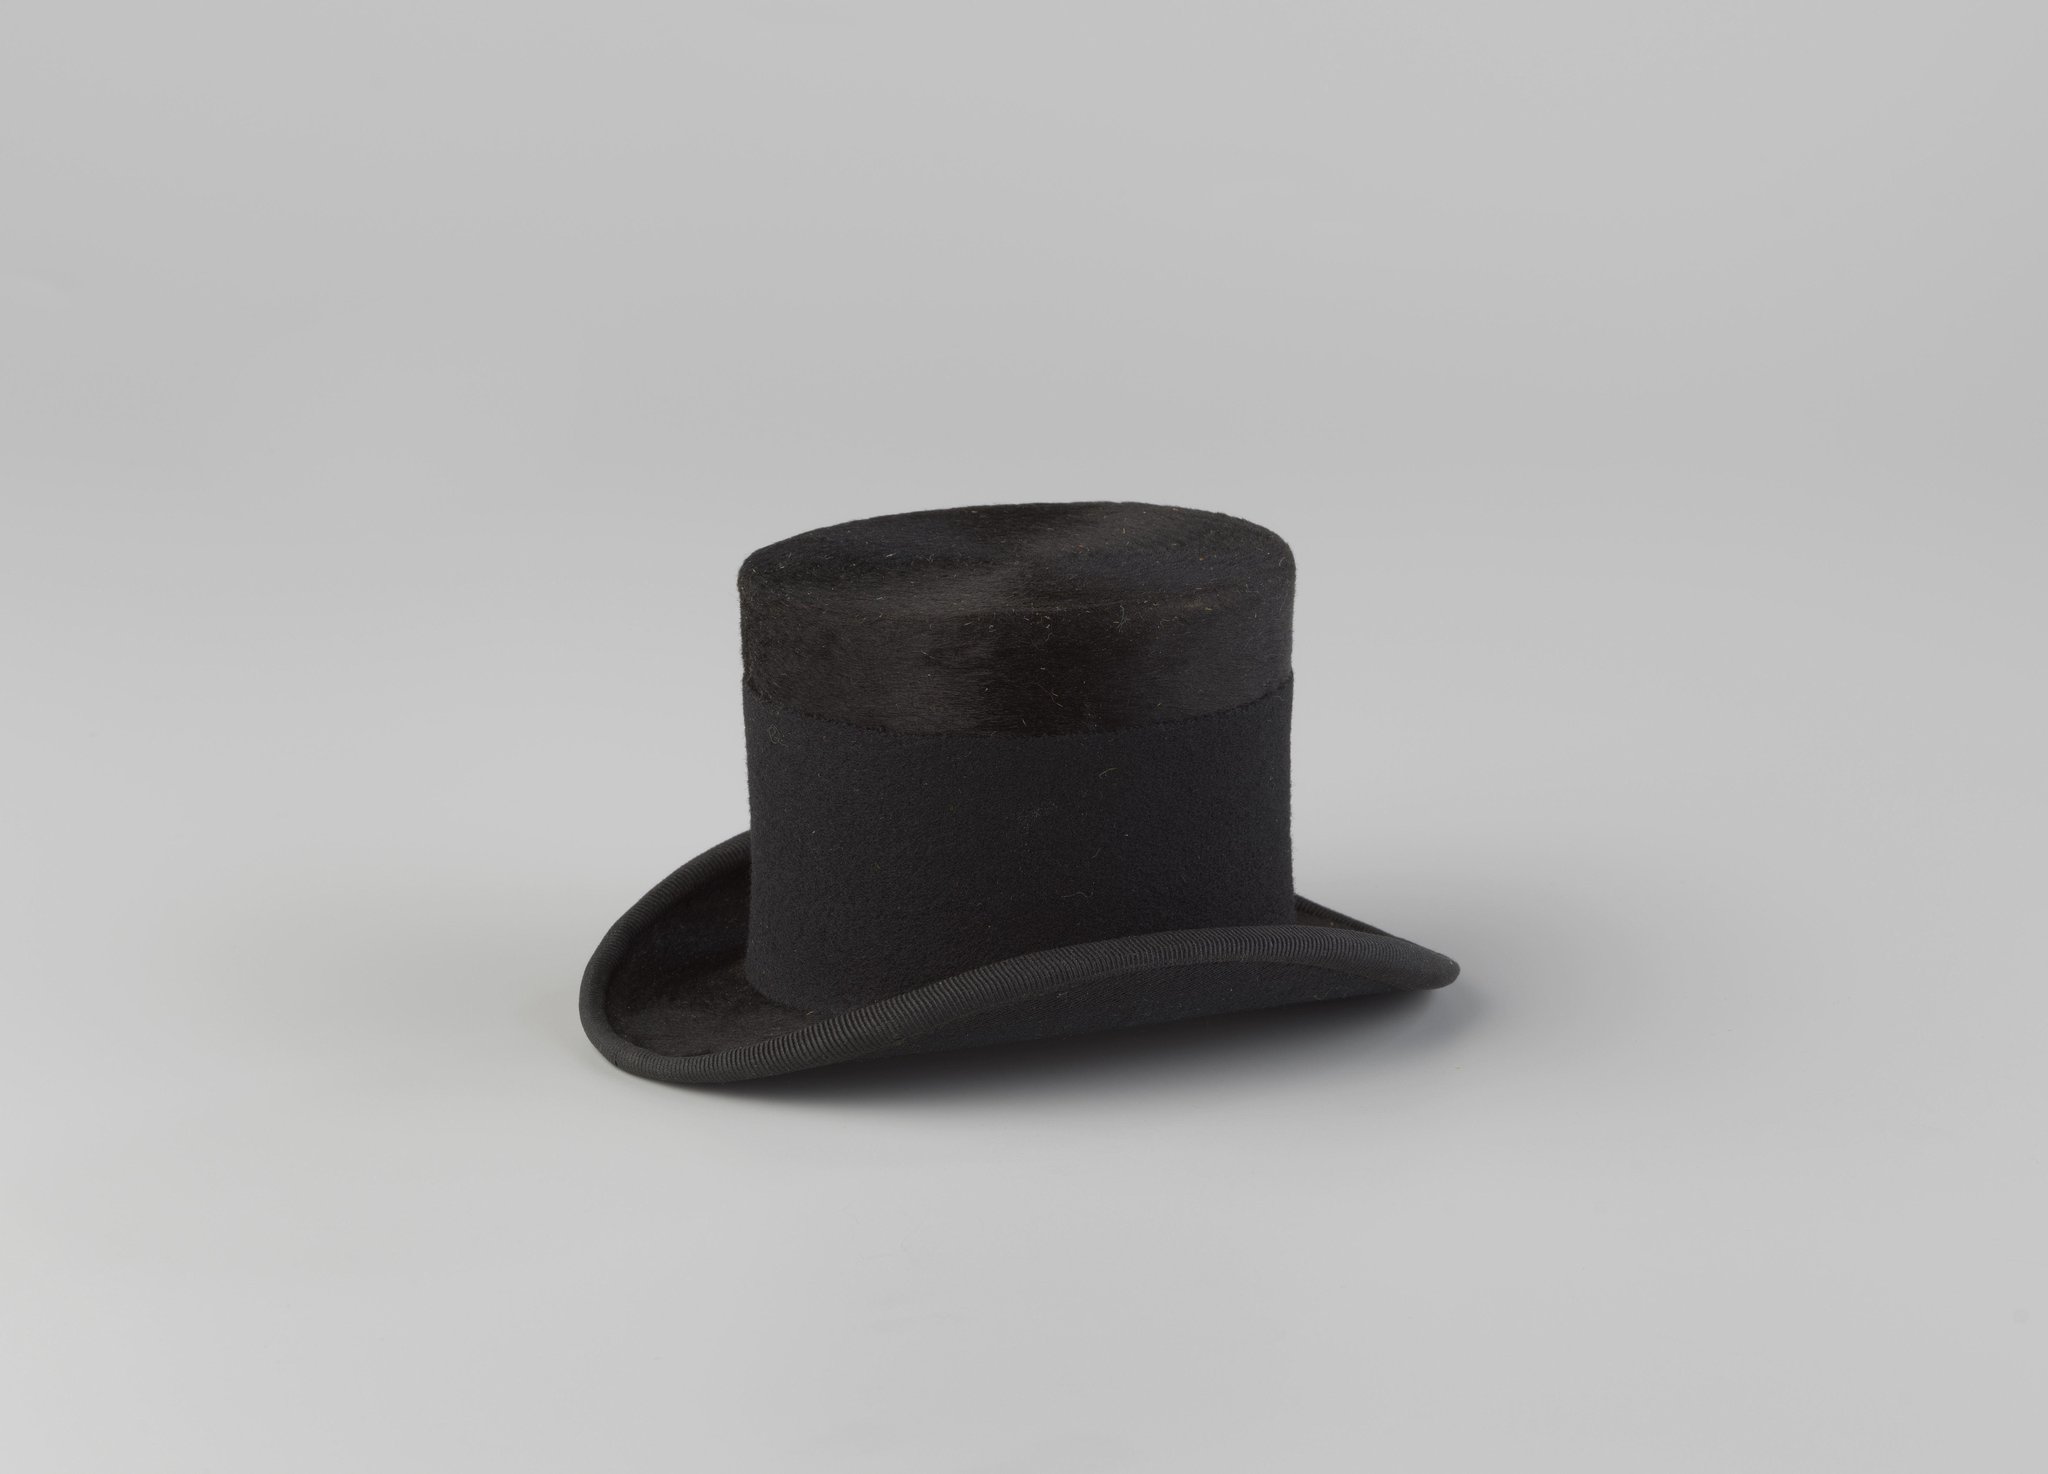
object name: menswear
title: Miniatuur hoge hoed van zwart zijden velours, met een zeer breed hoedelint van zwart vilt, winkelmodel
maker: Anonymous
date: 1901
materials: felt, leather, paper, silk, velvet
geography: england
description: Model: cylinderbol met ovale doorsnede en vlakke bodem. Rand met omgekrulde omtrek, opzij vrij hoog omhoog gewelfd. Voering: bodem van wit satijn met adres en een opstaande kant van papier; beige leren hoofdband met strikje. Adres in de kouseband: gekroond wapen van Groot-Brittannië en Ierland, met 'Hat manufactory/best quality'.